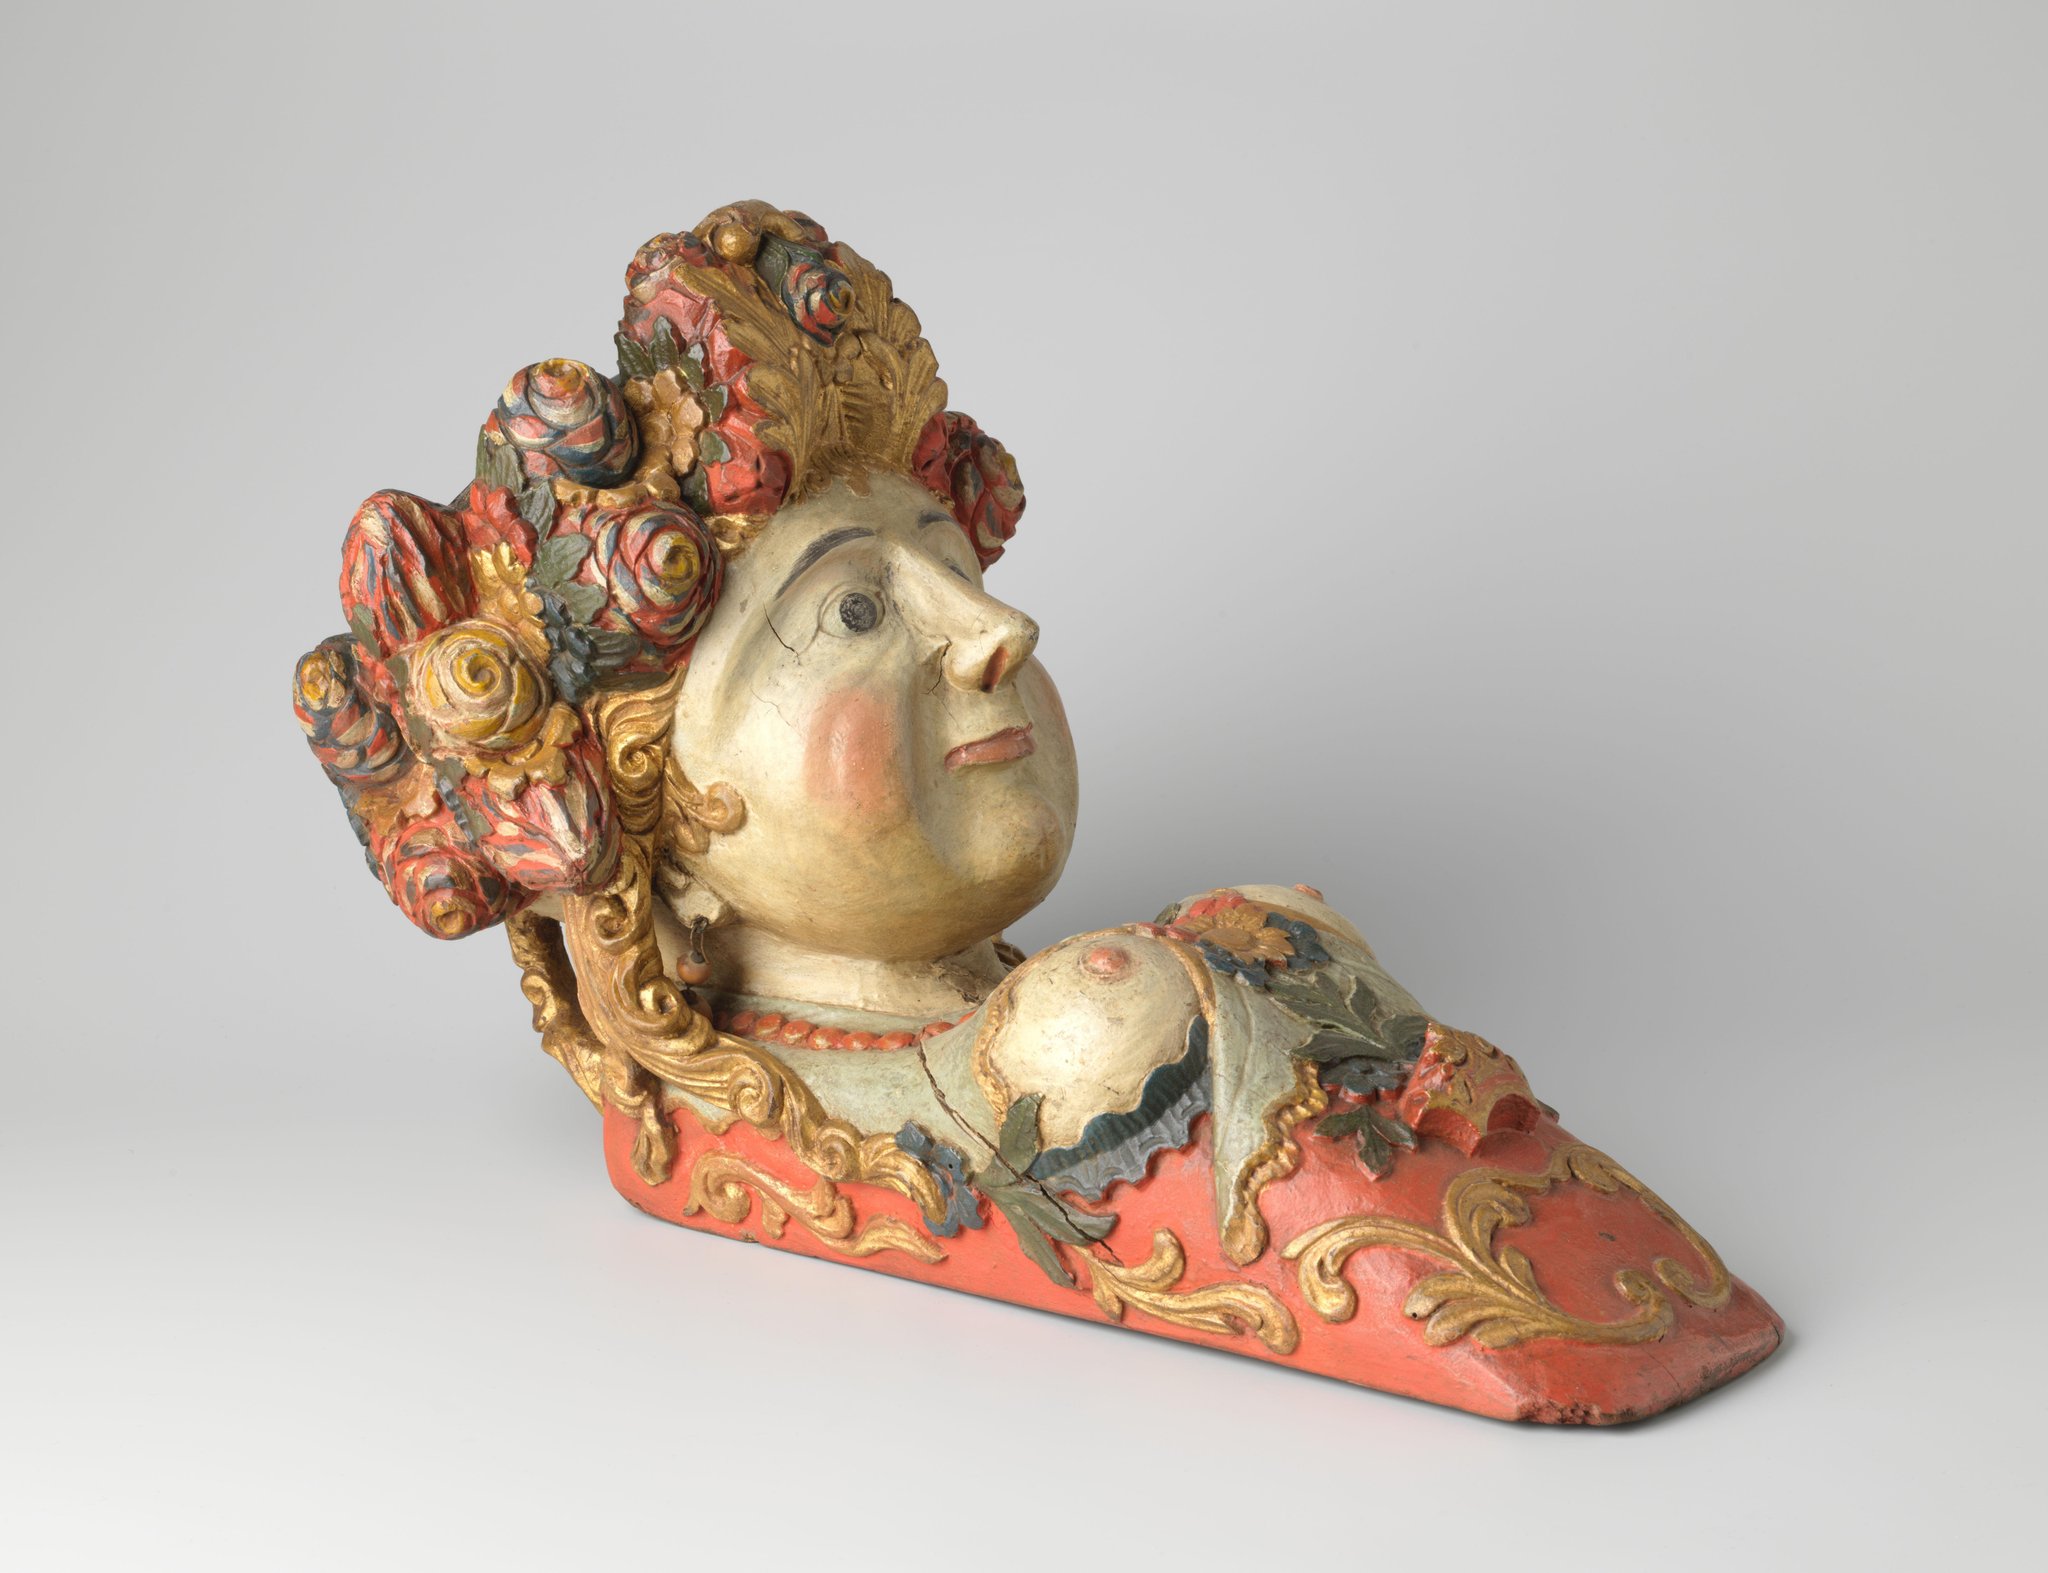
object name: roerkop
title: Roerkop met het borstbeeld van Flora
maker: Anonymous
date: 1700-1800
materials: copper, iron, leather, wood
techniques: cutting, forging, nailed, polychromy, turning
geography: netherlands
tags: specific aspects, allegorical aspects of flora; flora as patroness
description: Roerkop ter versiering van een Hollands binnenschip, voorstellende het borstbeeld van Flora, Italische godin van bloei van bloemen en veldgewas. Het hoofddeksel wordt gevormd door knoppen van waterlelies en ranken. Om de hals een snoer van kralen, 2 beweegbare oorbellen. Het geheel is versierd met plantmotieven. Op de achterzijde een ijzeren haak voor bevestiging van het roer. De borsten rusten op het wigvormige roodgeschilderde onderstuk, dat een kroon vertoont in het midden en 2 ranken in goud. Opschrift.